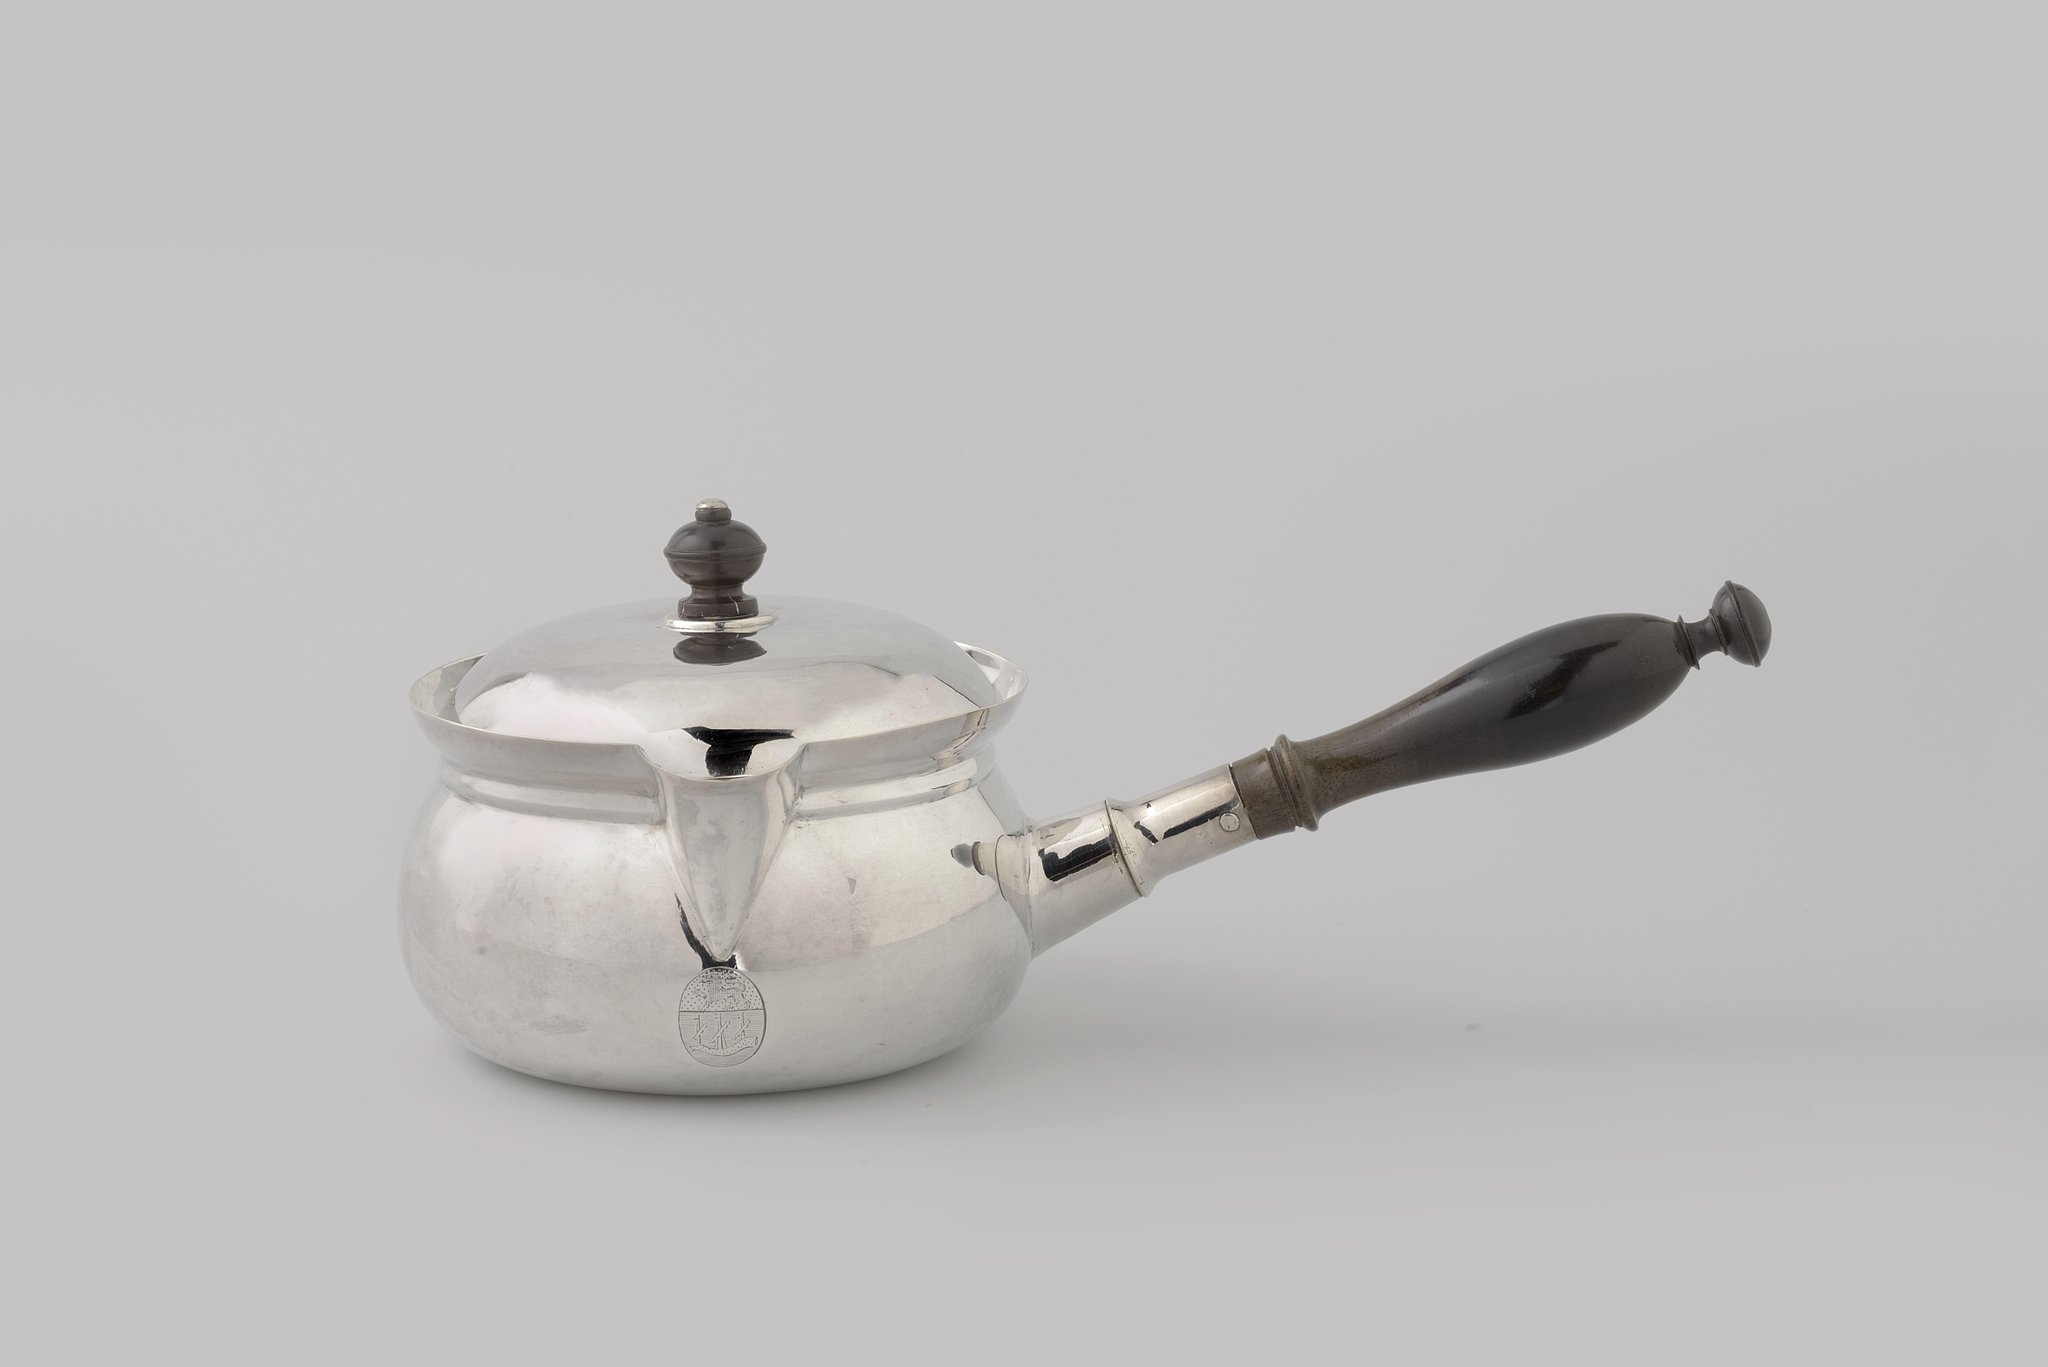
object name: saucepan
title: Steelpan met deksel met het familiewapen Van Beaumont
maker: jan hendrik middelhuysen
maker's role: silversmith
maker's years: 1746-1822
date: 1793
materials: wood, silver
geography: amsterdam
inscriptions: town mark, : ‘L’, maker's mark, duty mark, alloy mark, date letter: ‘I’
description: Steelpan of porringer met deksel met het familiewapen Van Beaumont. Het gedrukt bolvormige lichaam heeft een bolle uitstaande bovenrand, die aan de onderzijde begrensd is door een brede ribbel, en die overgaat over in een snebvormige tuit. Halverwege het lichaam steekt de ebbenhouten balustervormige geprofileerde steel schuin omhoog; hij is gestoken in een uit twee delen opgebouwde zilveren vatting. Het losse, gewelfde deksel heeft in het midden een lage ronde verhoging waarop de bolvormige, geprofileerde, ebbenhouten knop, bekroond door een klein zilveren bolletje, is bevestigd. Onder de tuit is het wapen Van Beaumont gegraveerd.